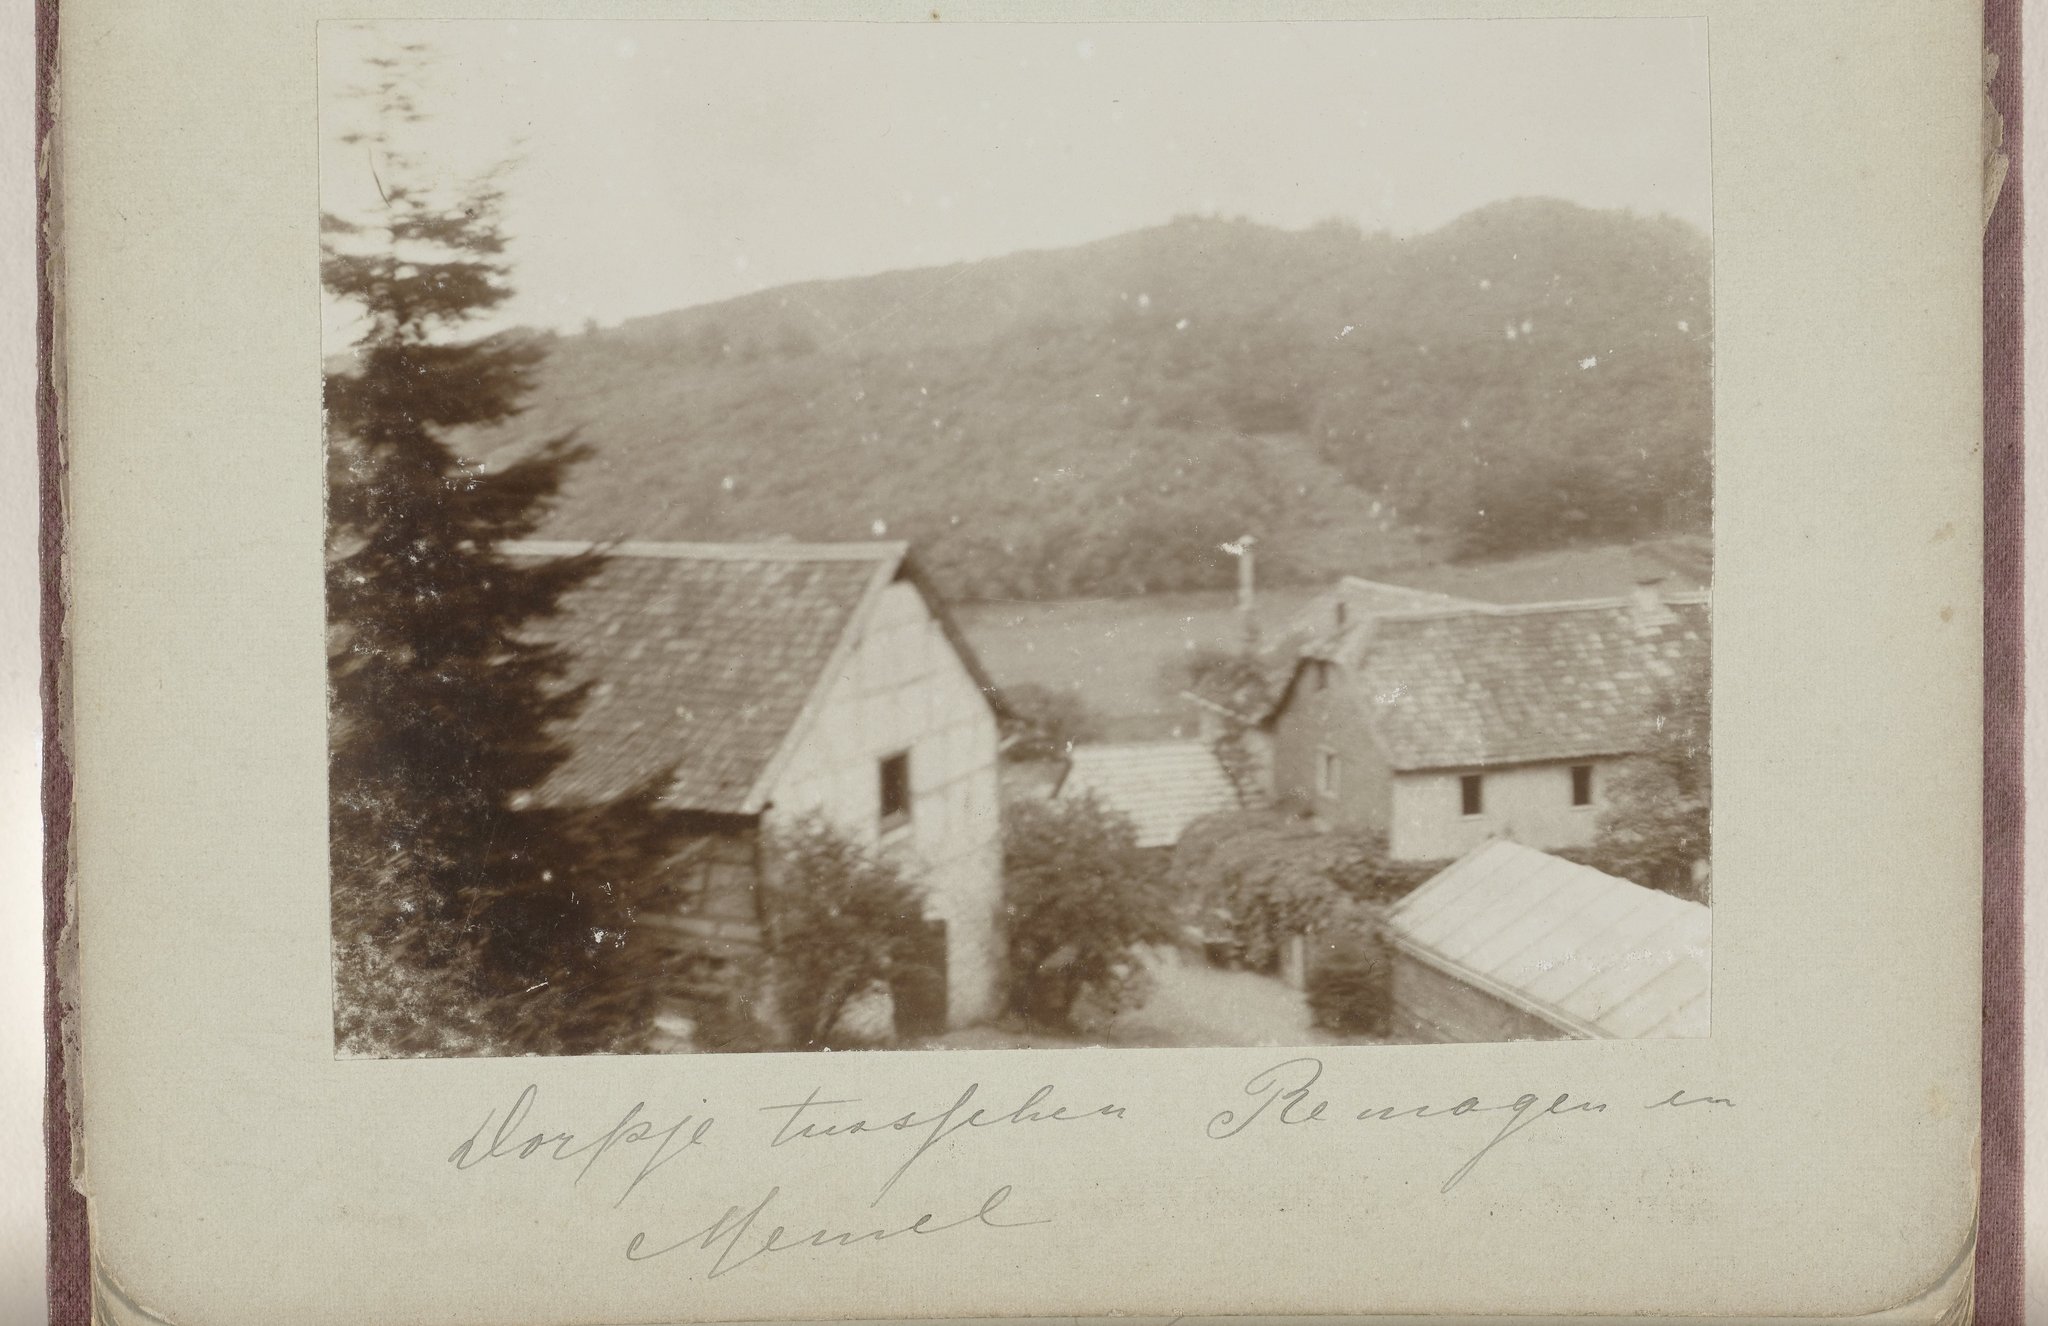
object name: album leaf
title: Dorpsgezicht tussen Remagen en Mehlem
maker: david vermeulen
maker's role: fotograaf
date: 1895-1905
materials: paper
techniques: collodion silver print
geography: north rhine-westphalia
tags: prospect of village, silhouette of village